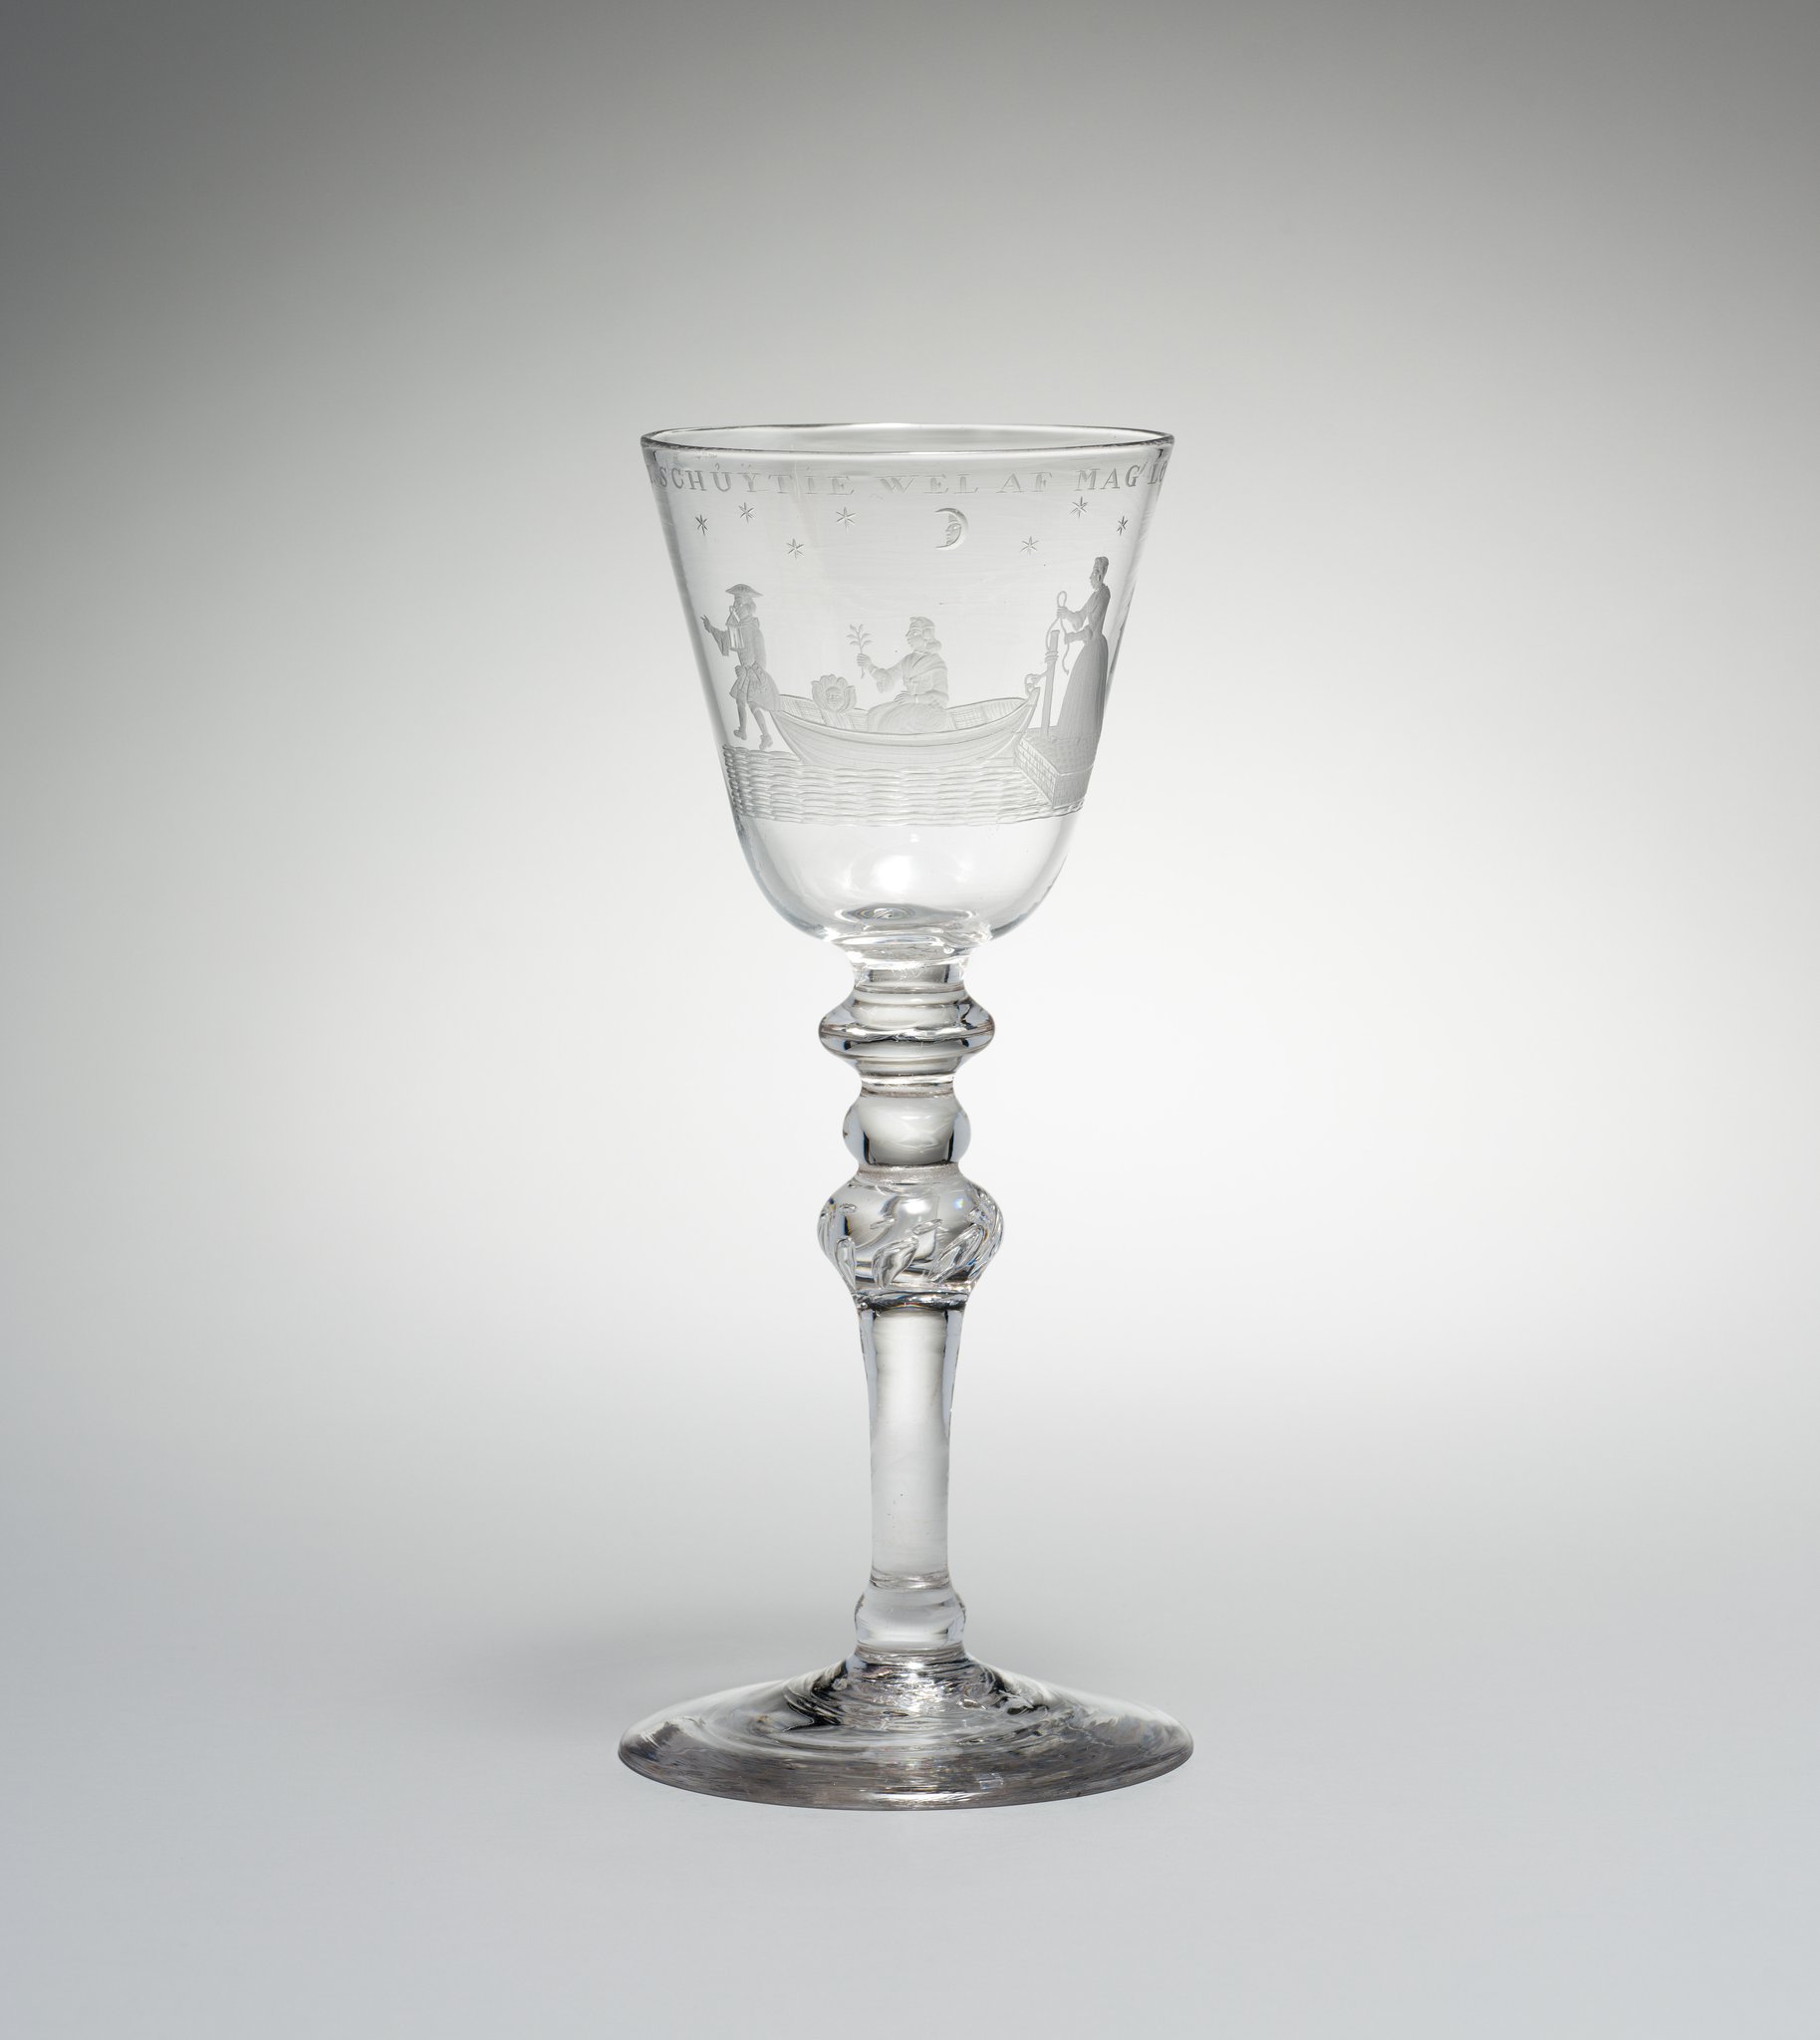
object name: wine goblet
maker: simon jacob sang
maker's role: engraver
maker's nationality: dutch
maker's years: 1720-1786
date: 1751-1775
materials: glass, lead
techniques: engraving